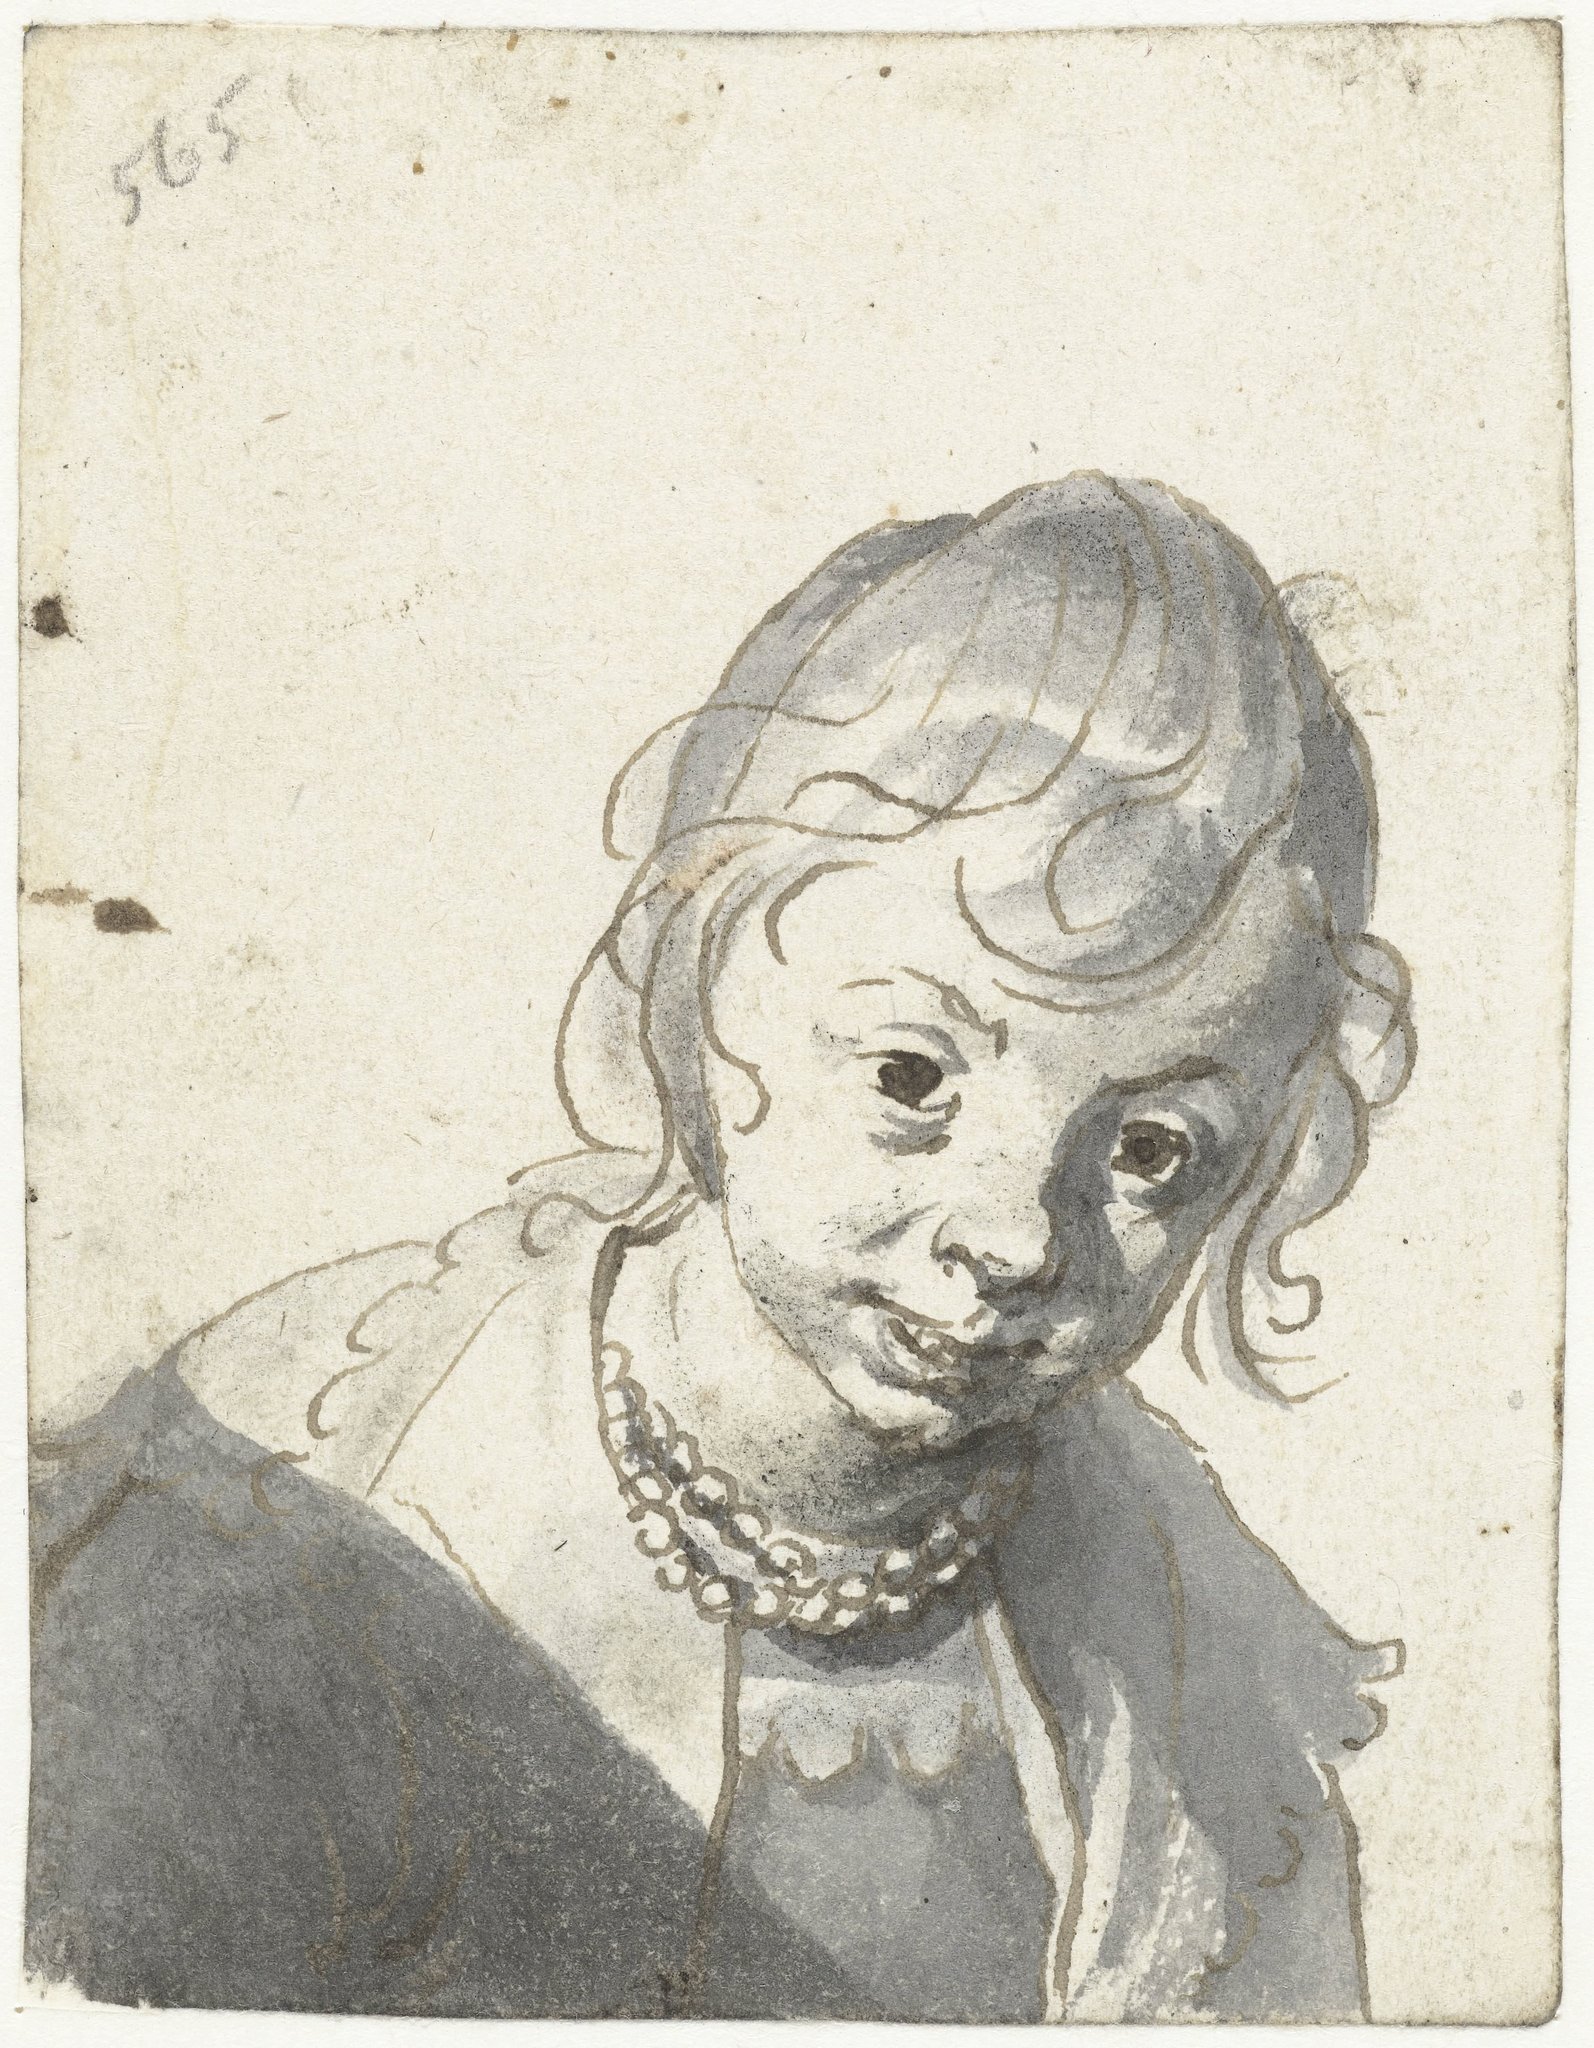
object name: drawing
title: Portrait of a Girl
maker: gerard ter borch (i)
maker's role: draughtsman, print maker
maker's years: 1584-1662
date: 1630-1635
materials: chalk, ink, paper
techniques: brush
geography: zwolle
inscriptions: inscription: ‘GT Borch Sr.’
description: Although Gerard ter Borch did not pursue a career as a professional artist, he continued to draw throughout his life. He also instructed five of his thirteen children (from three marriages) in the rudiments of drawing. Along with copying prints, limning family members was a useful exercise. The artist here probably drew a portrait of his daughter Sara.